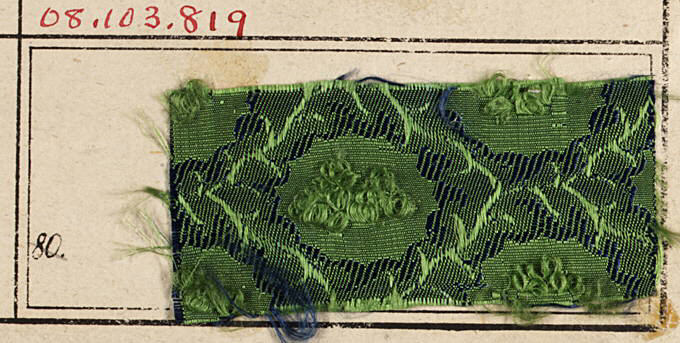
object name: ribbon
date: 1701-1900